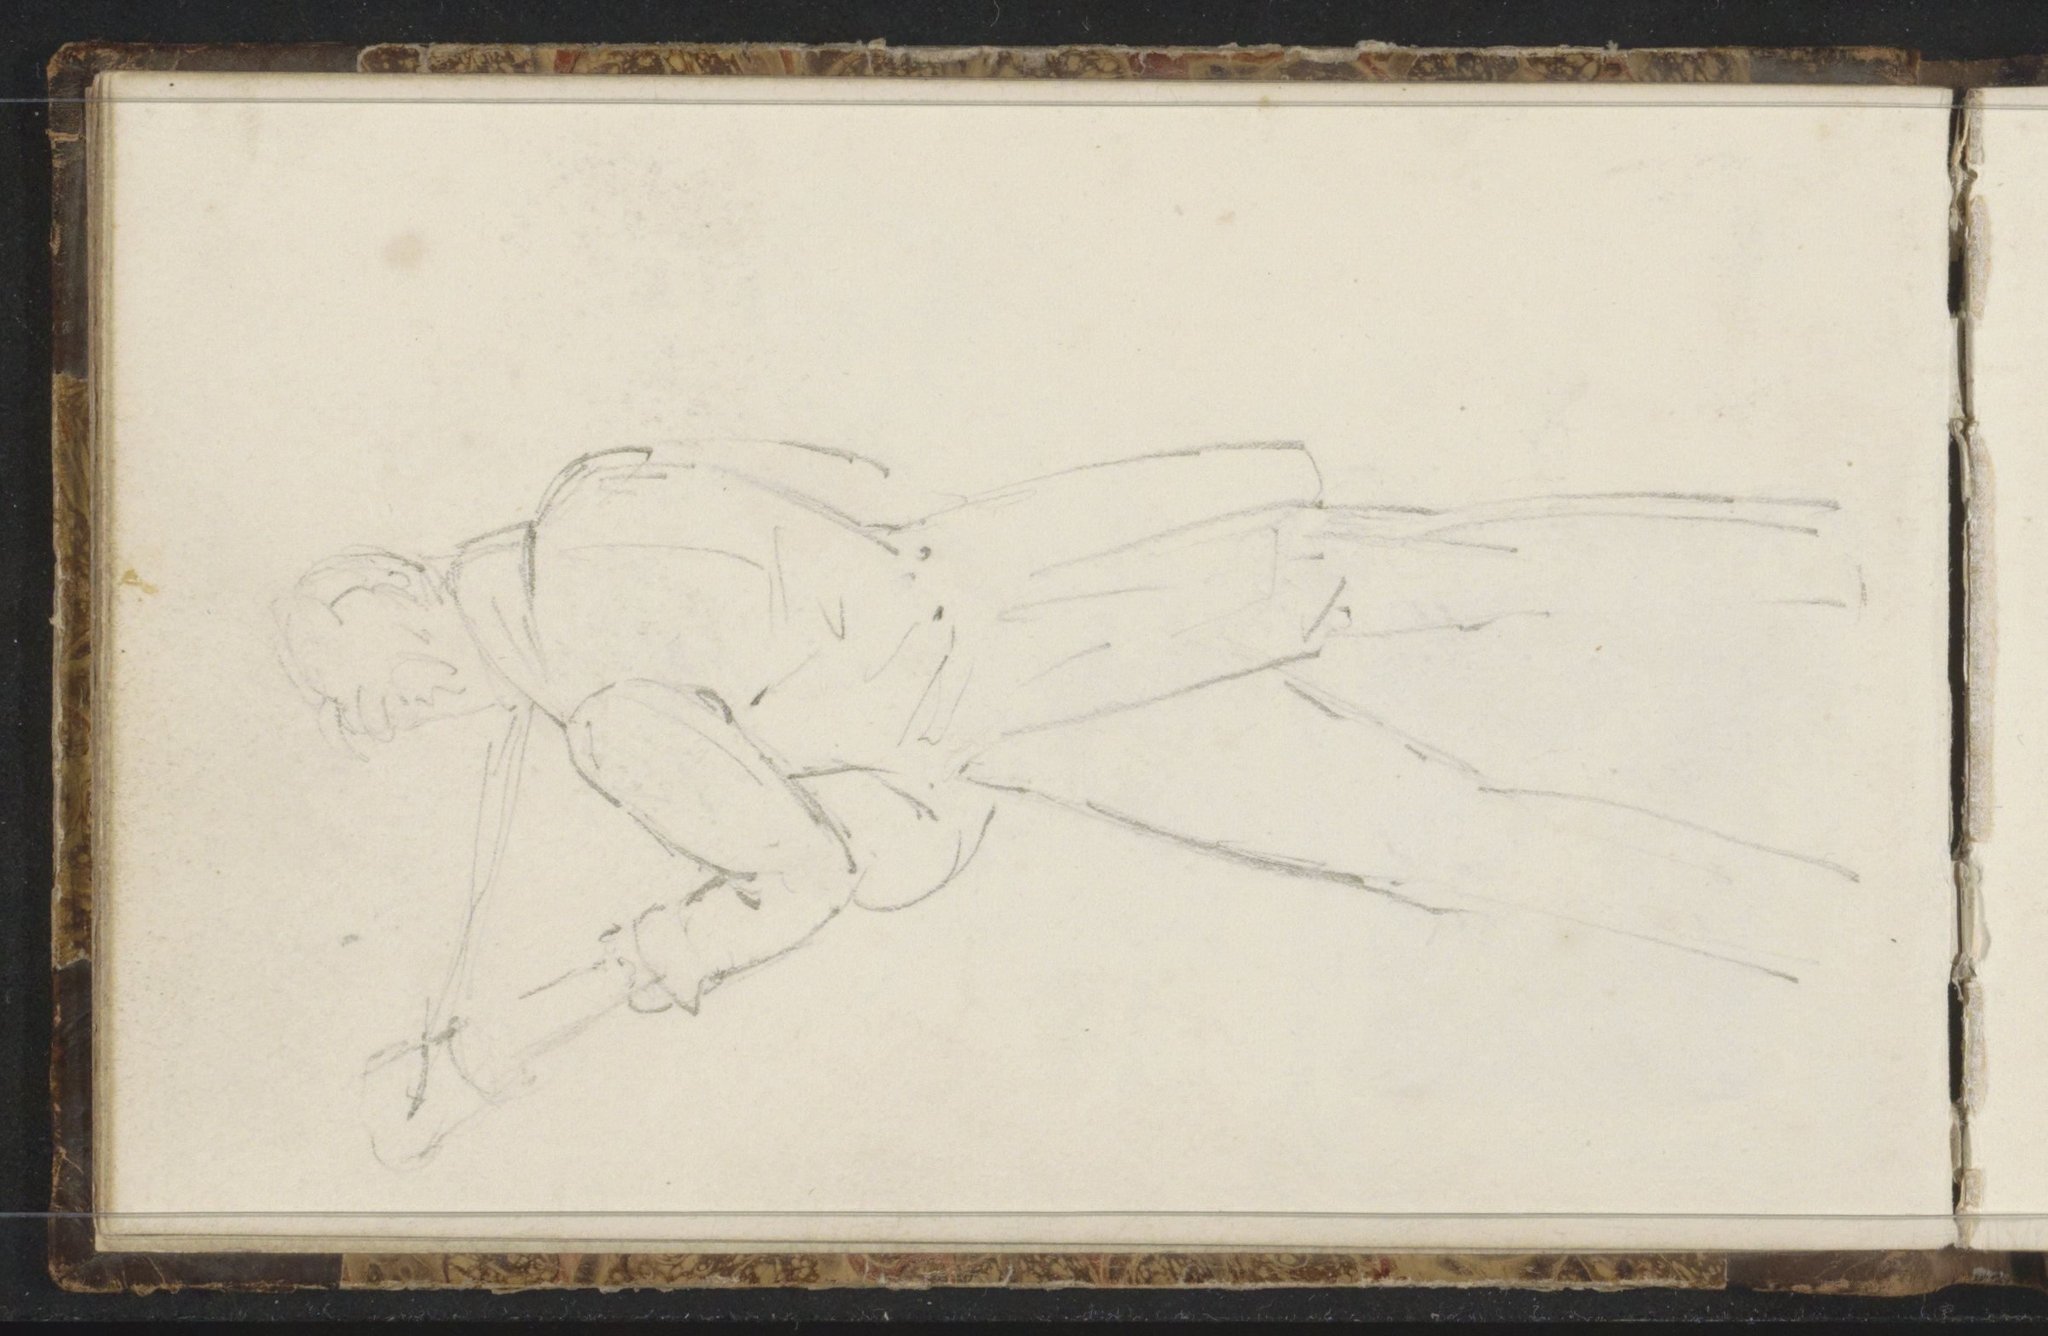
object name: sketchbook leaf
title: Staande man die de krant leest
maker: willem hendrik schmidt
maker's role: draughtsman, painter, print maker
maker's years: 1809-1849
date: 1819-1849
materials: paper, pencil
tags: standing figure, reading, newspaper, news-sheet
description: Blad 7 verso uit een schetsboek met 60 bladen.